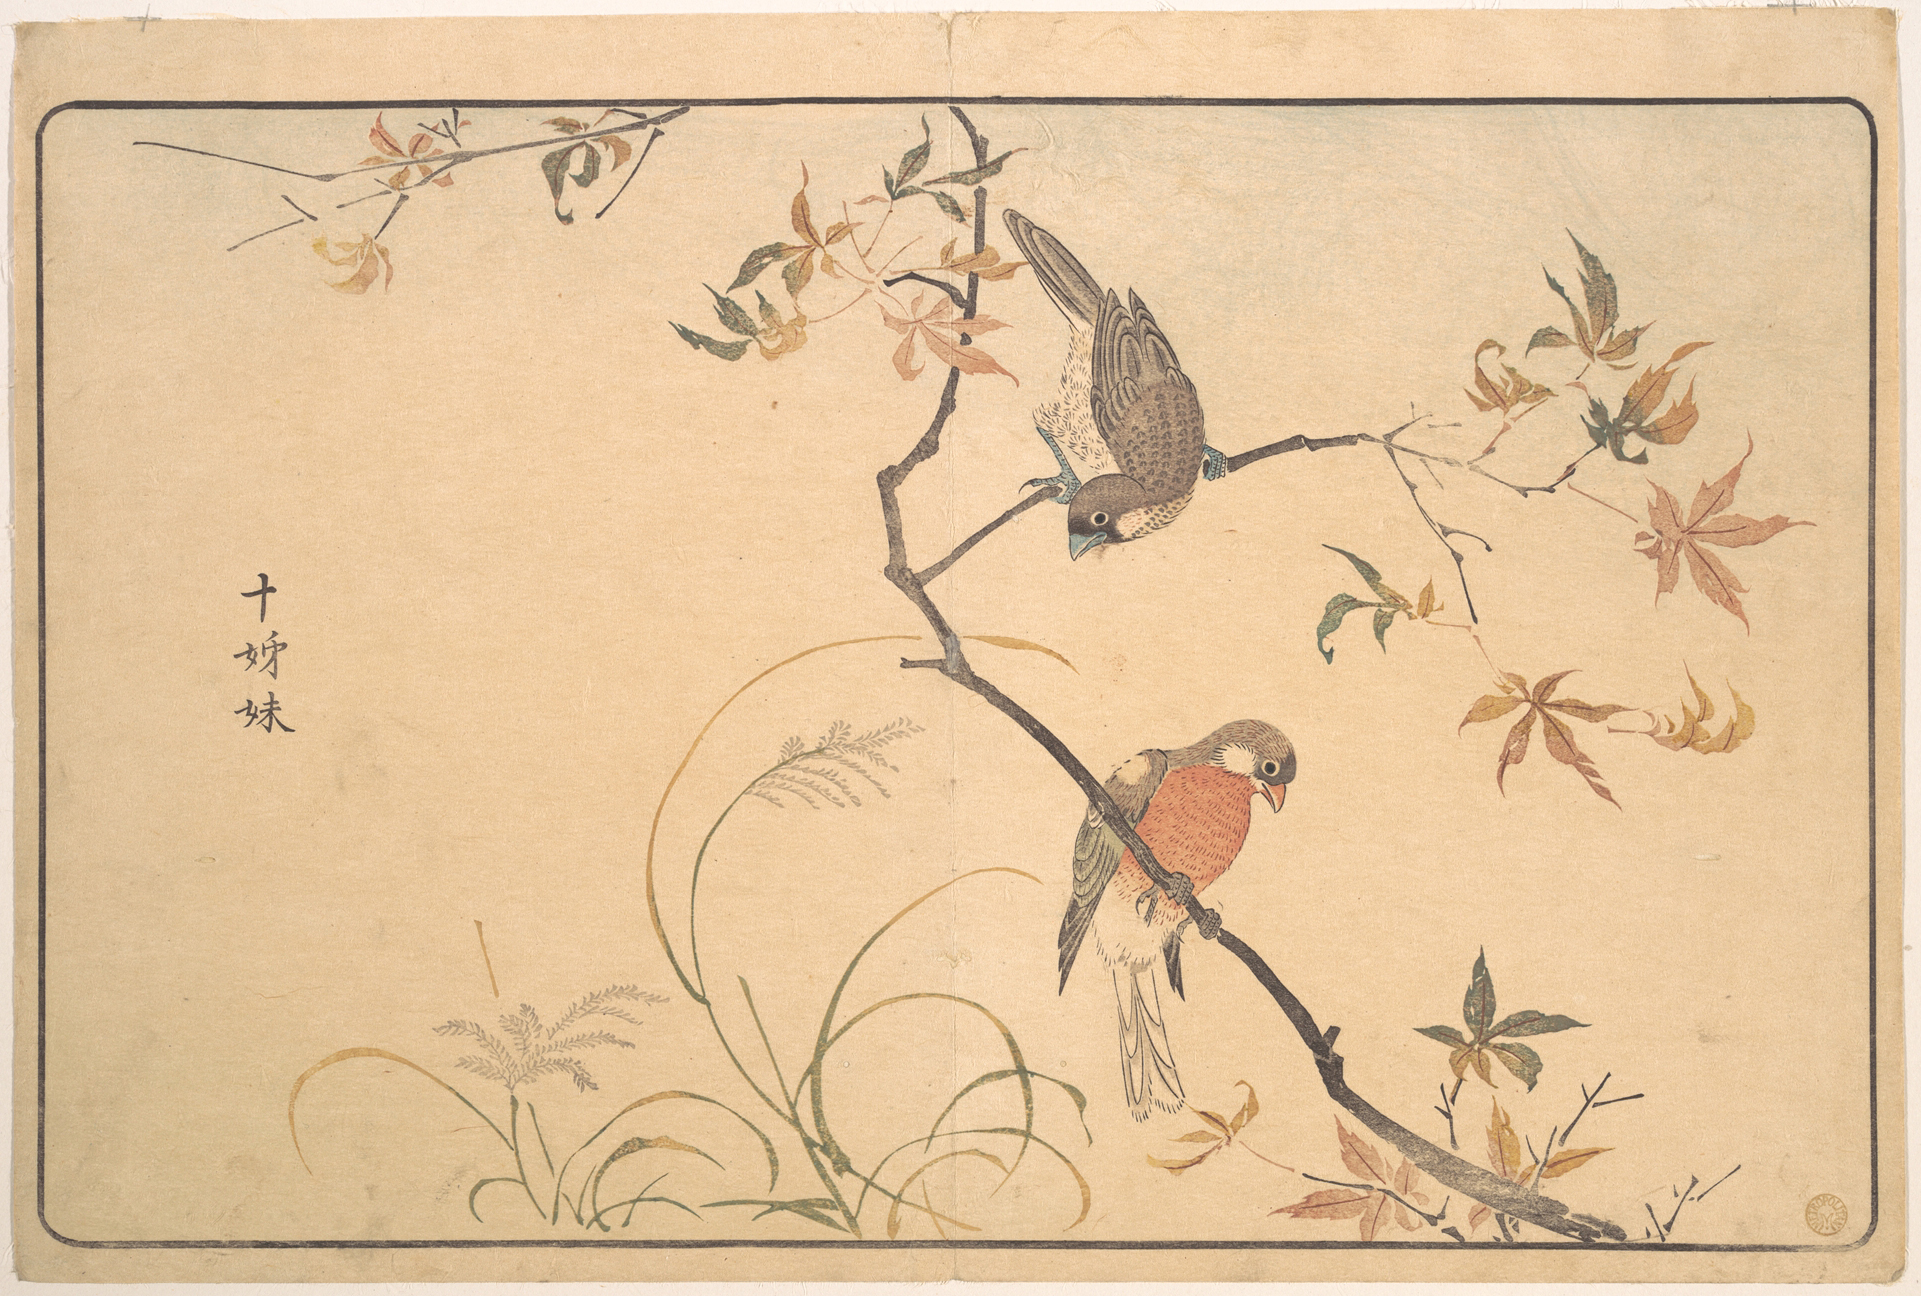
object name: print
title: Jūshimatsu (Begalee or a society finch)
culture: japanese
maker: kuwagata keisai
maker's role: artist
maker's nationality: japanese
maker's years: 1764-1824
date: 1789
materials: ink, paper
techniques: woodblock print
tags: birds,leaves